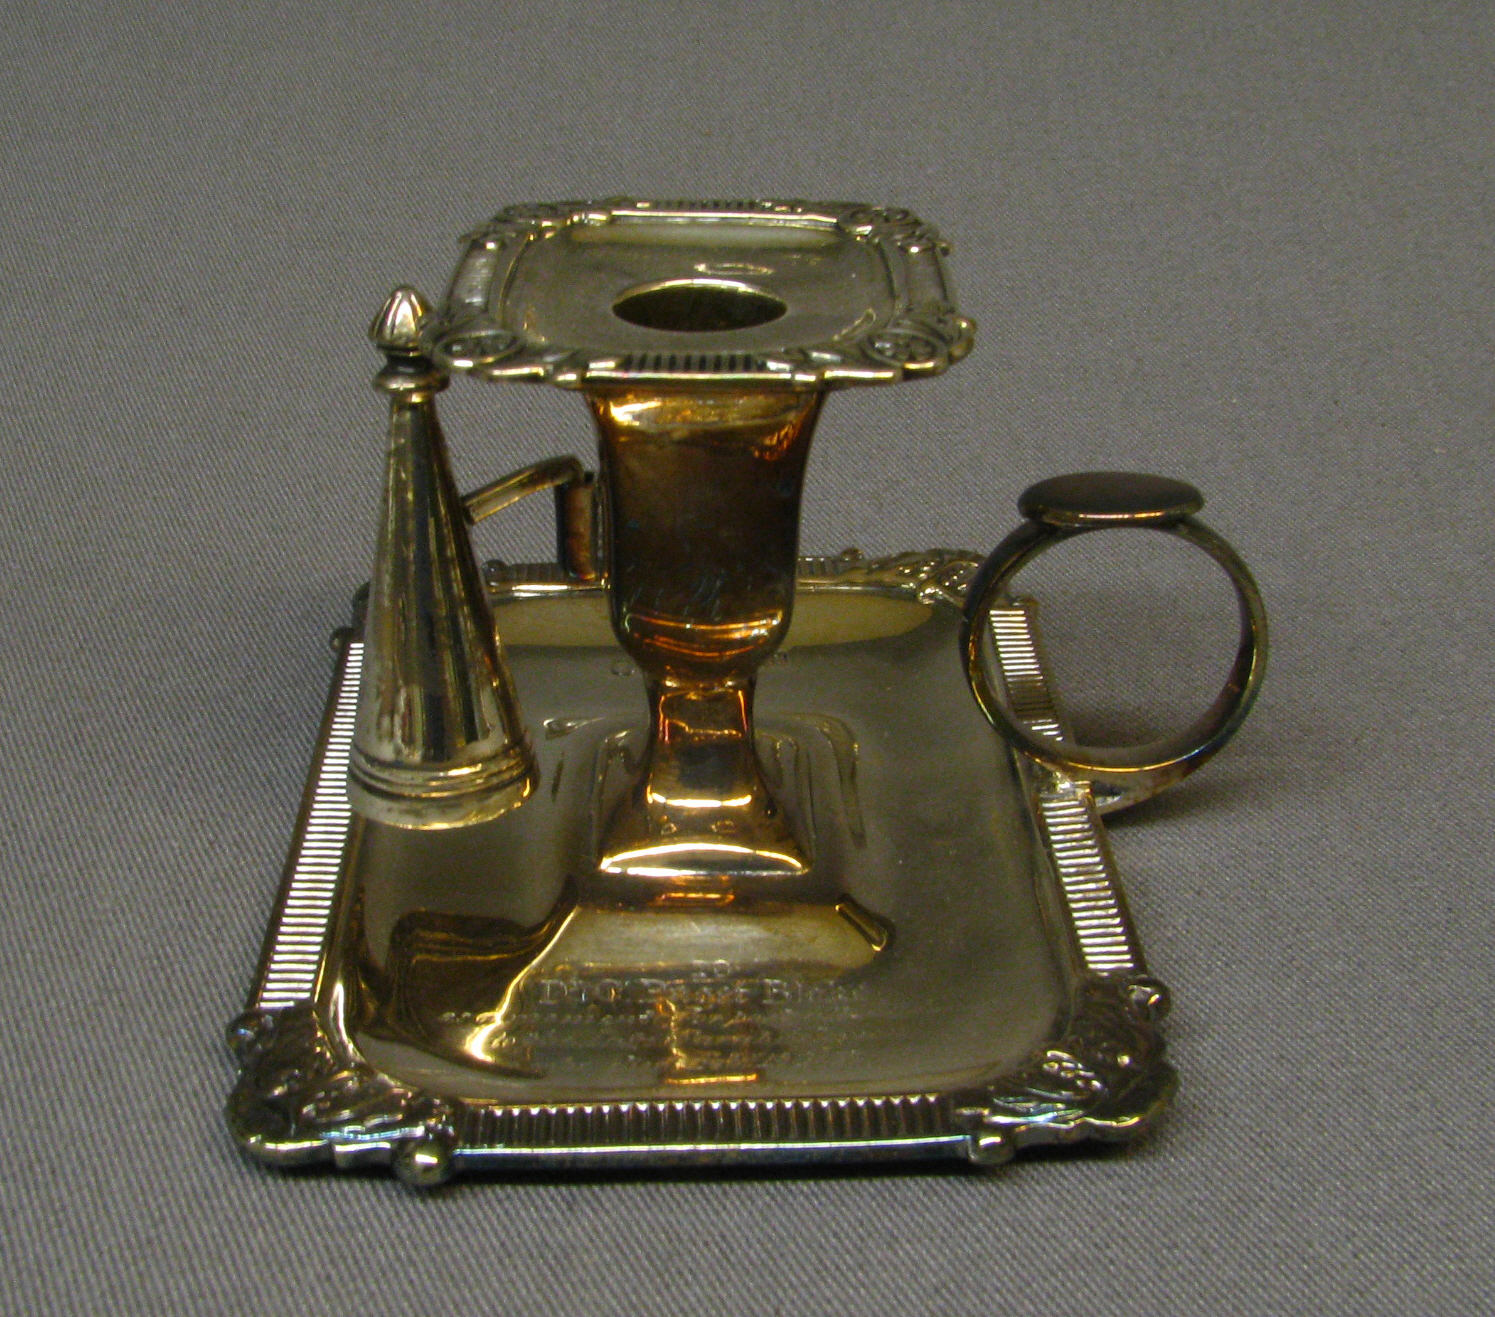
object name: chamber candlestick or taperstick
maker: charles lias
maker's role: maker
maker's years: 1823-1846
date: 1828-1829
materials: silver